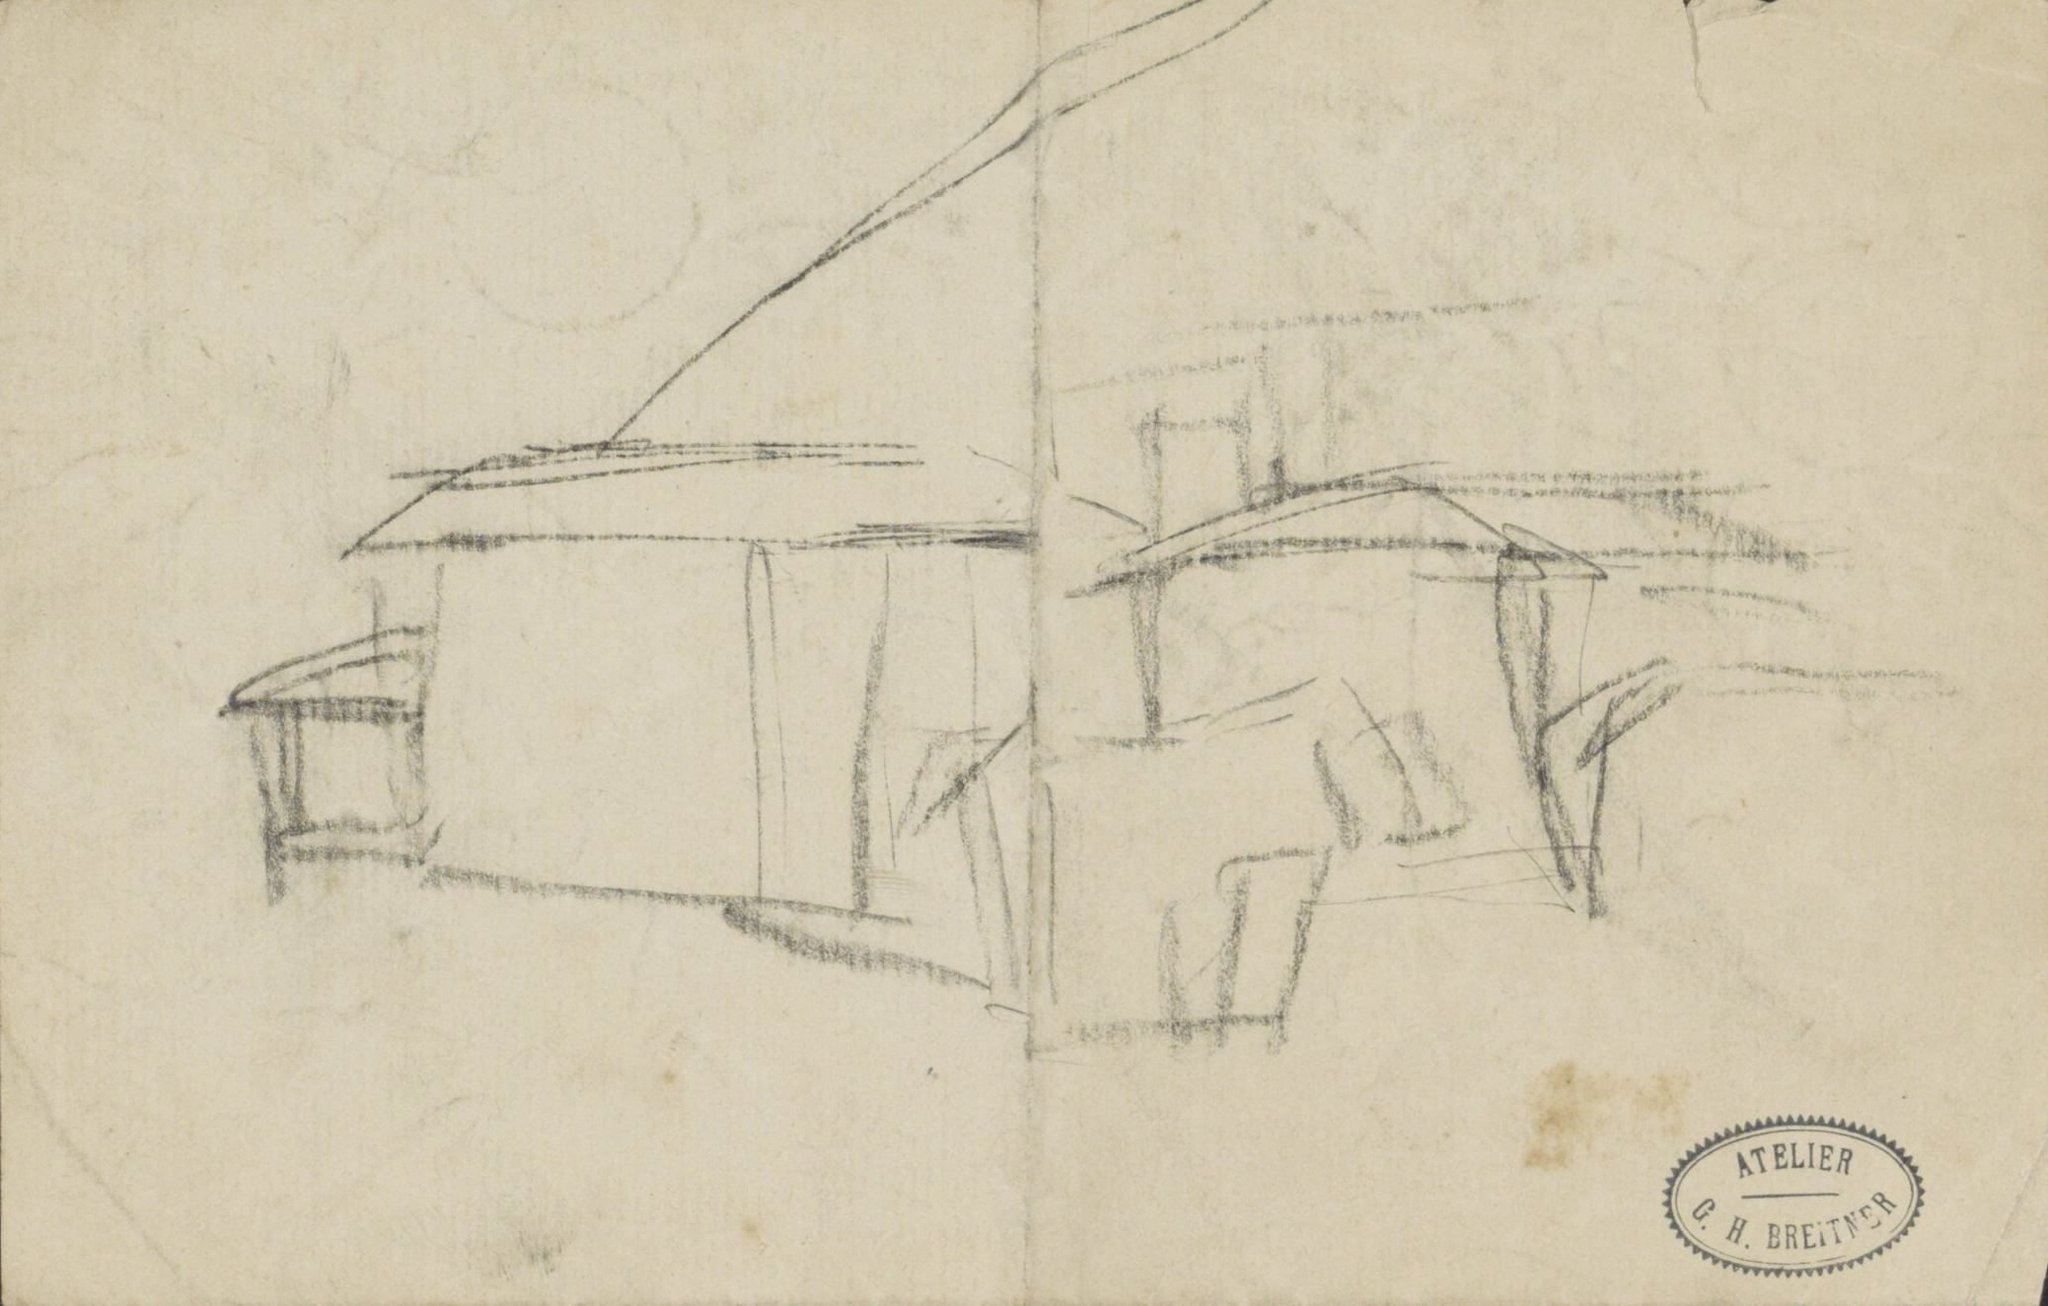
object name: drawing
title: Paardentram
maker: george hendrik breitner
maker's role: draughtsman, painter, print maker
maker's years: 1857-1923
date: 1886-1923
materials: chalk, paper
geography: amsterdam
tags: diligence, omnibus, horse-tram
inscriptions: collector's mark: Lugt 2228, workshop stamp: Lugt 291d